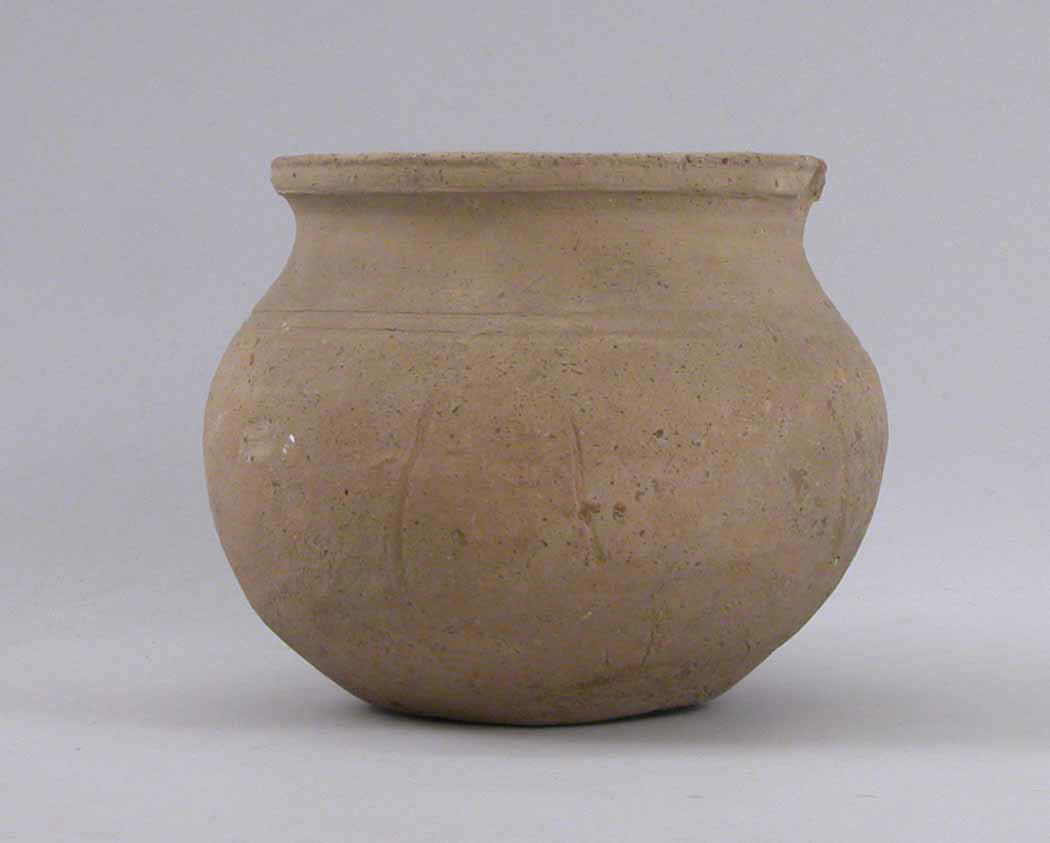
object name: bowl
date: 801-1000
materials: earthenware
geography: iran